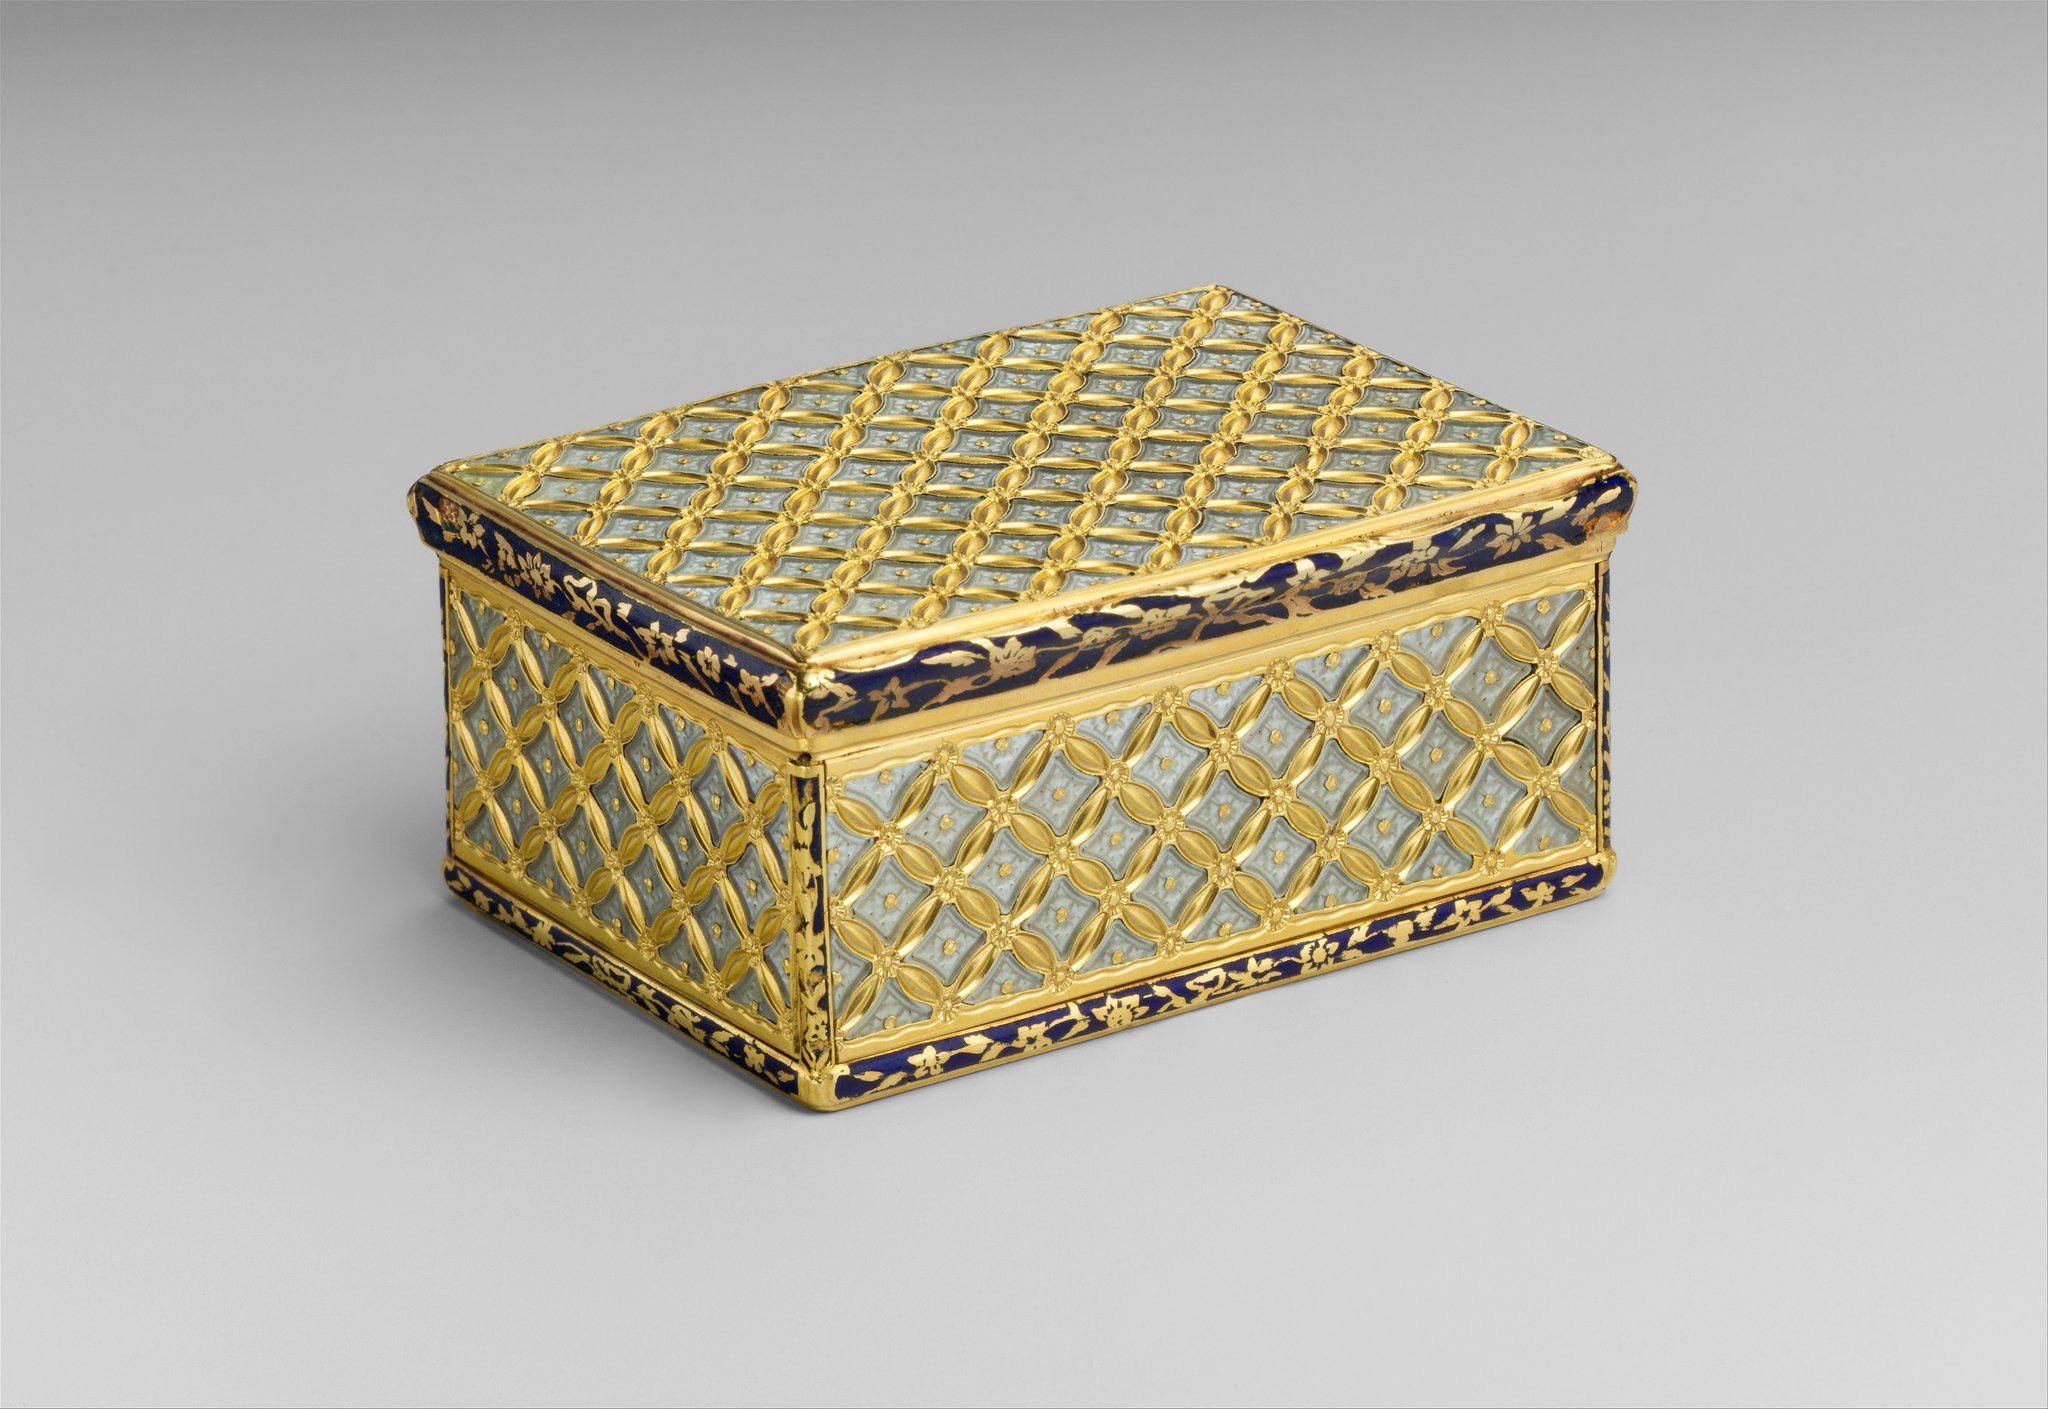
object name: box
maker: jean ducrollay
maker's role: maker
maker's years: 1709-1760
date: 1739-1740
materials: enamel, gold, mother of pearl